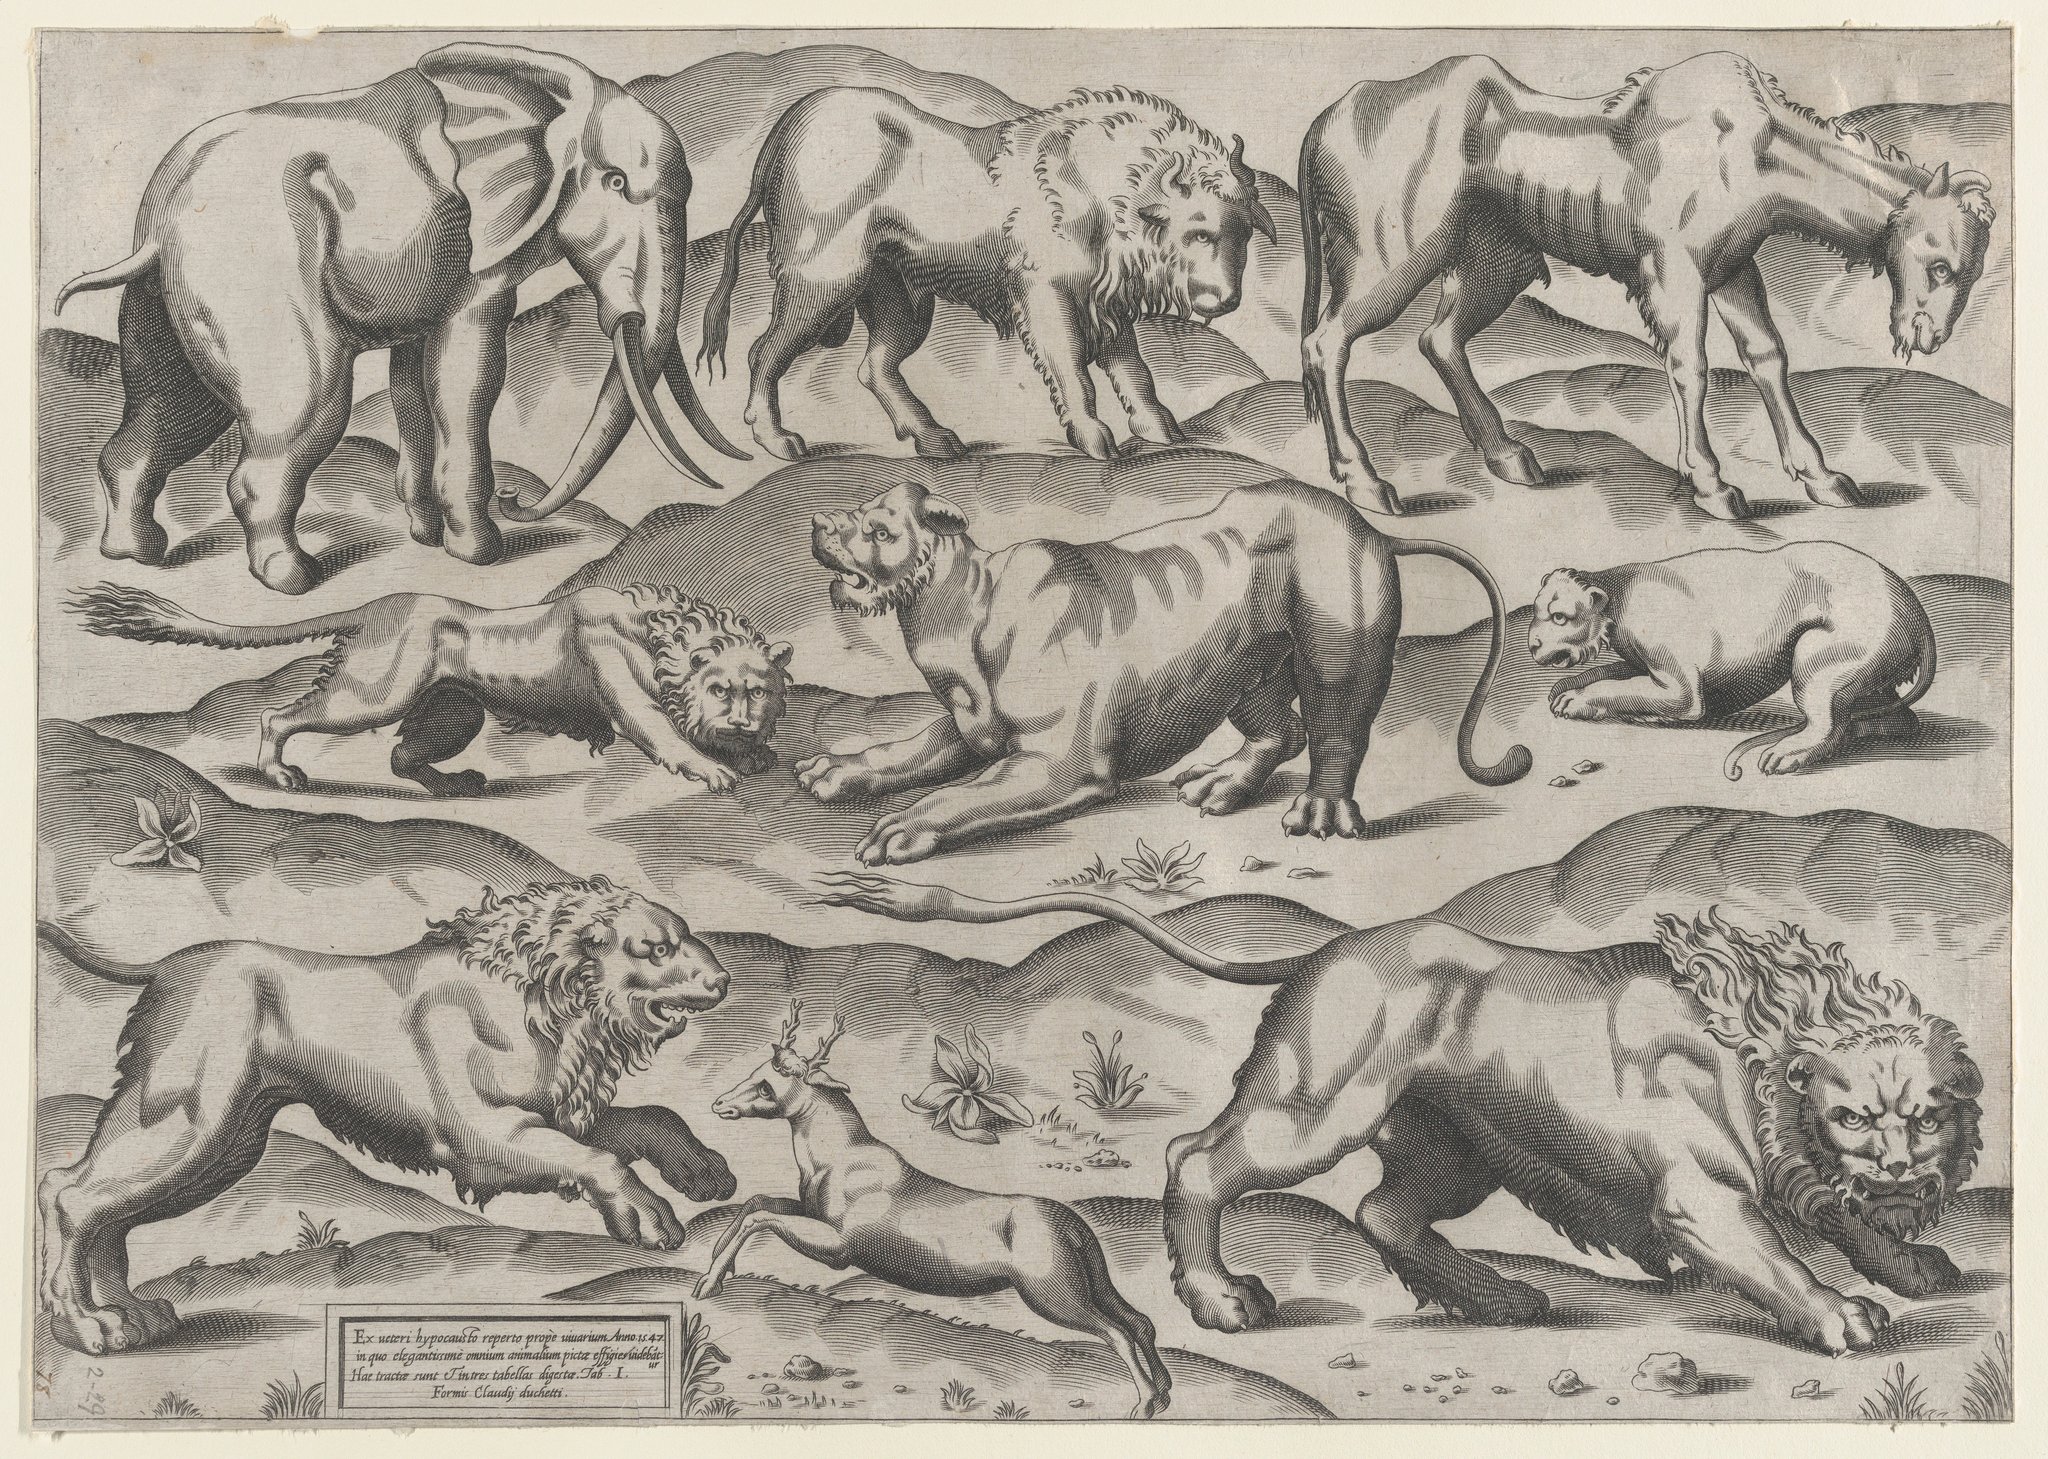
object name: print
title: Wild Animals, from antique wall paintings, plate 1, from "Speculum Romanae Magnificentiae"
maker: Anonymous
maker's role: artist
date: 1567-1600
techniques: engraving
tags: deer,elephants,lions